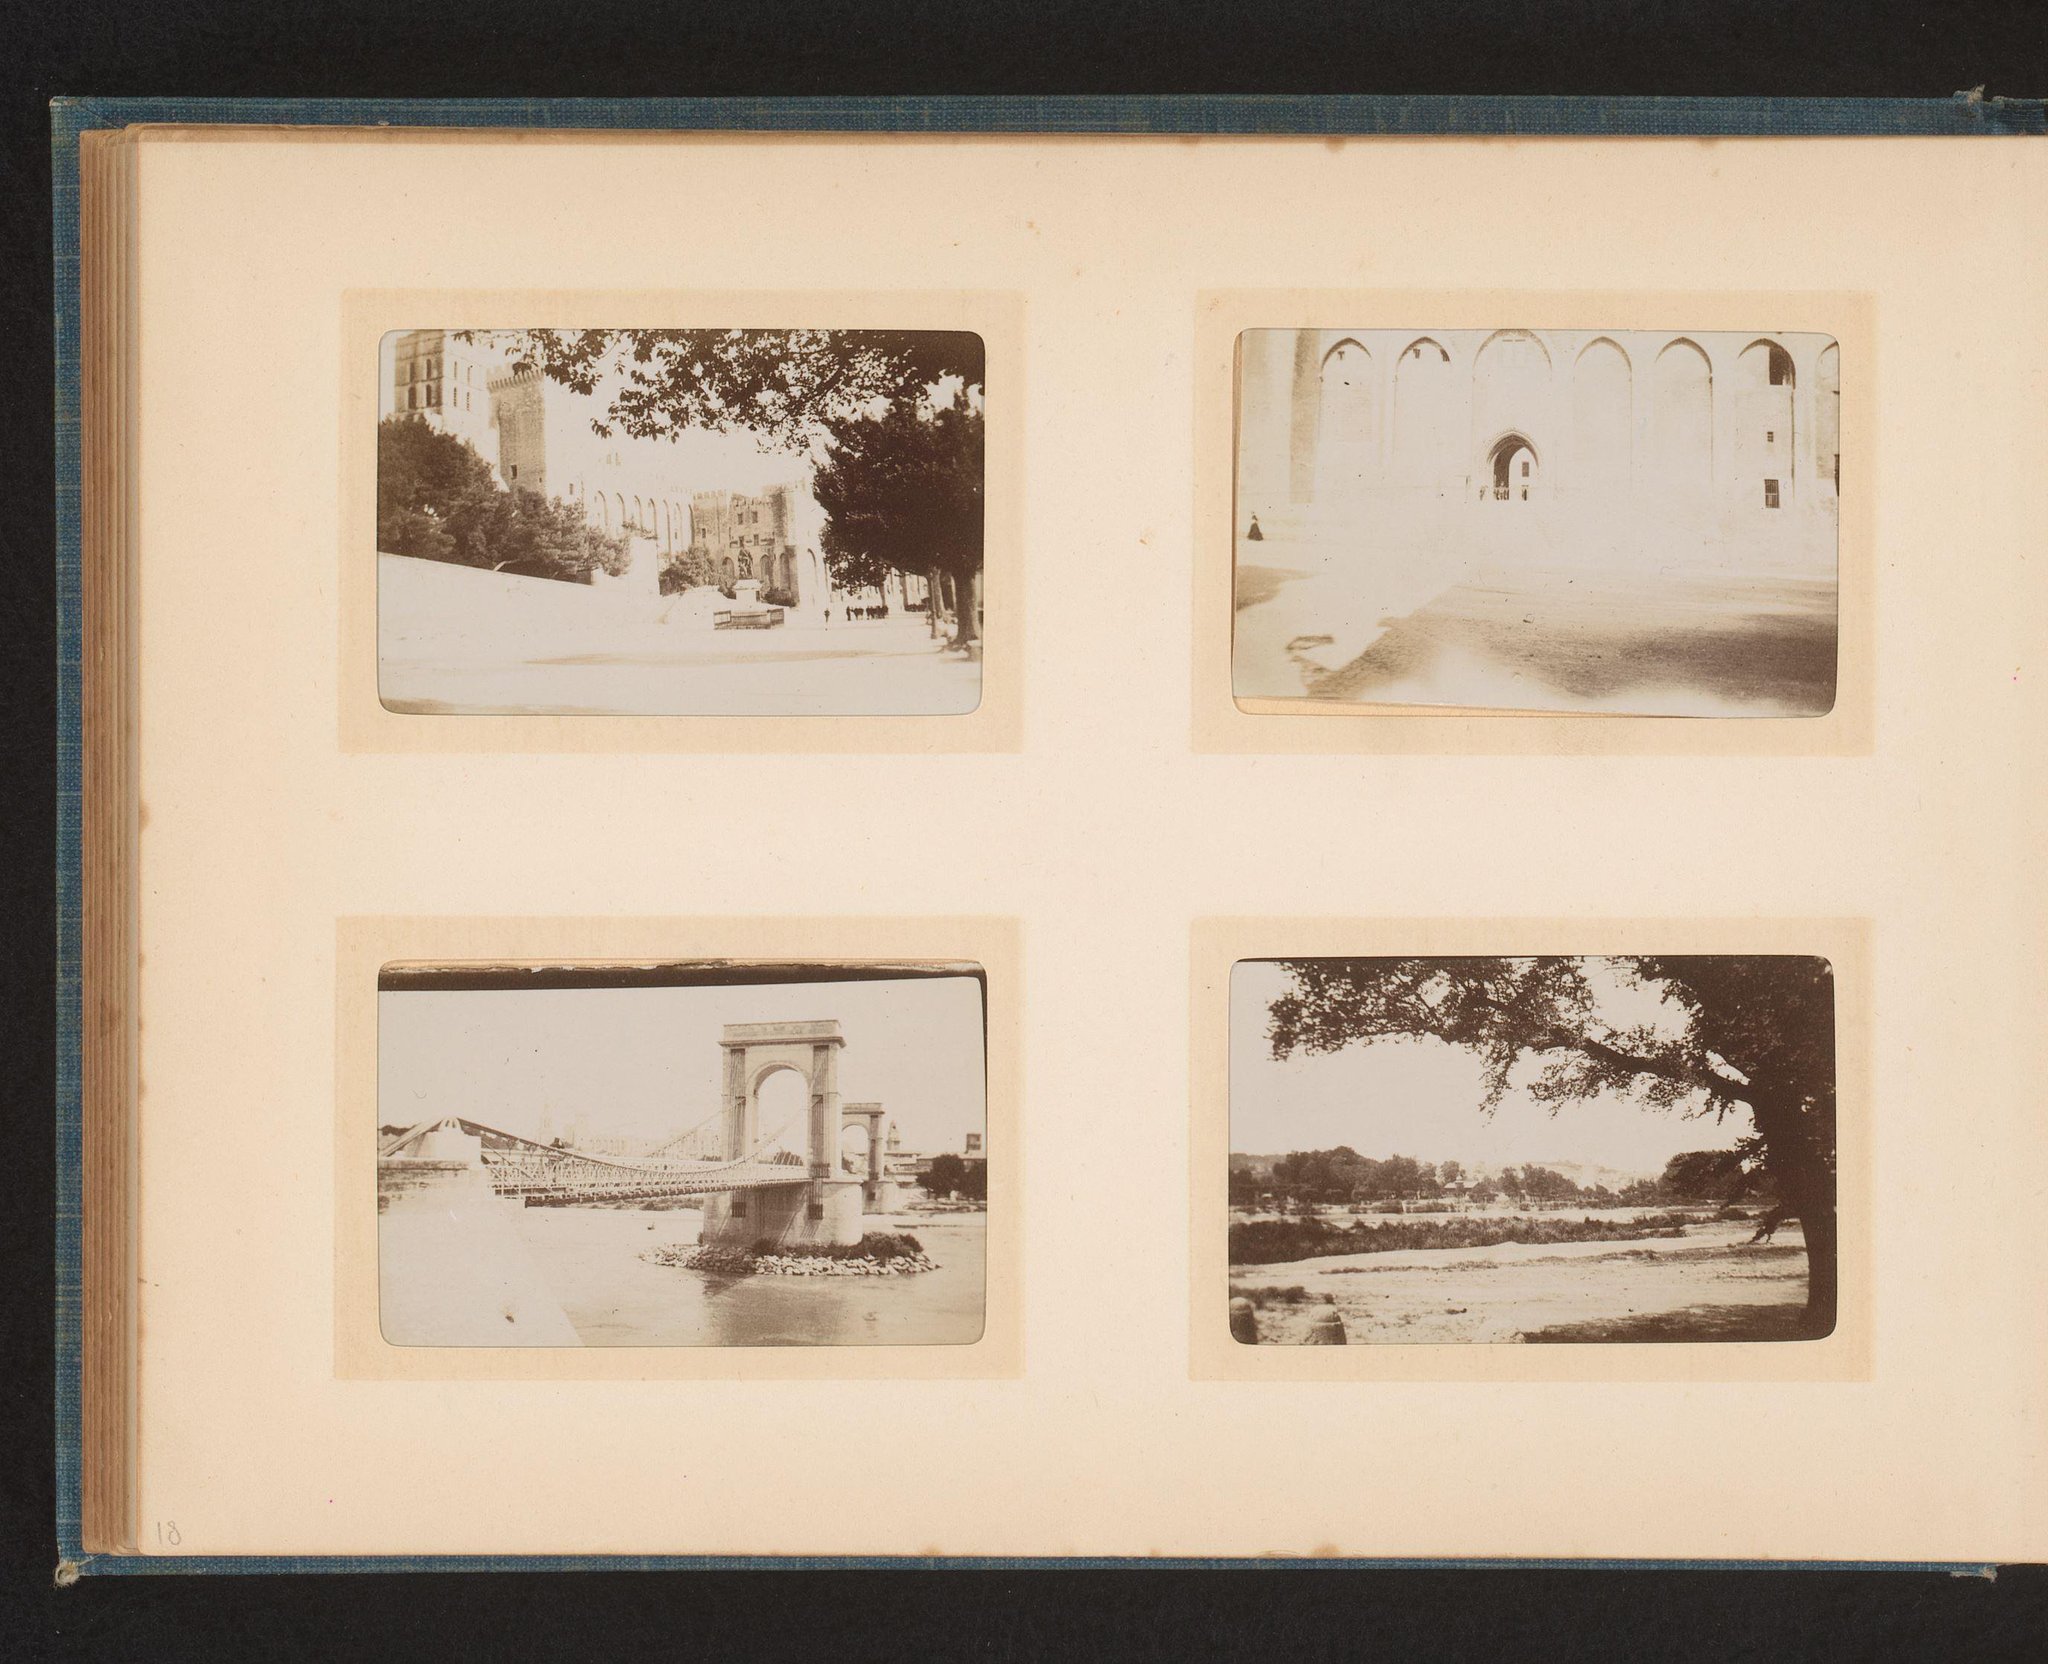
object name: album leaf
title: Twee gezichten op gebouwen, Gezicht op een brug en Landschap te Frankrijk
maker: Anonymous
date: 1900-1915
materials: paper, photographic support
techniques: gelatin silver print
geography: france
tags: landscapes, travelling; tourism, bridge, civic architecture; edifices; dwellings, france